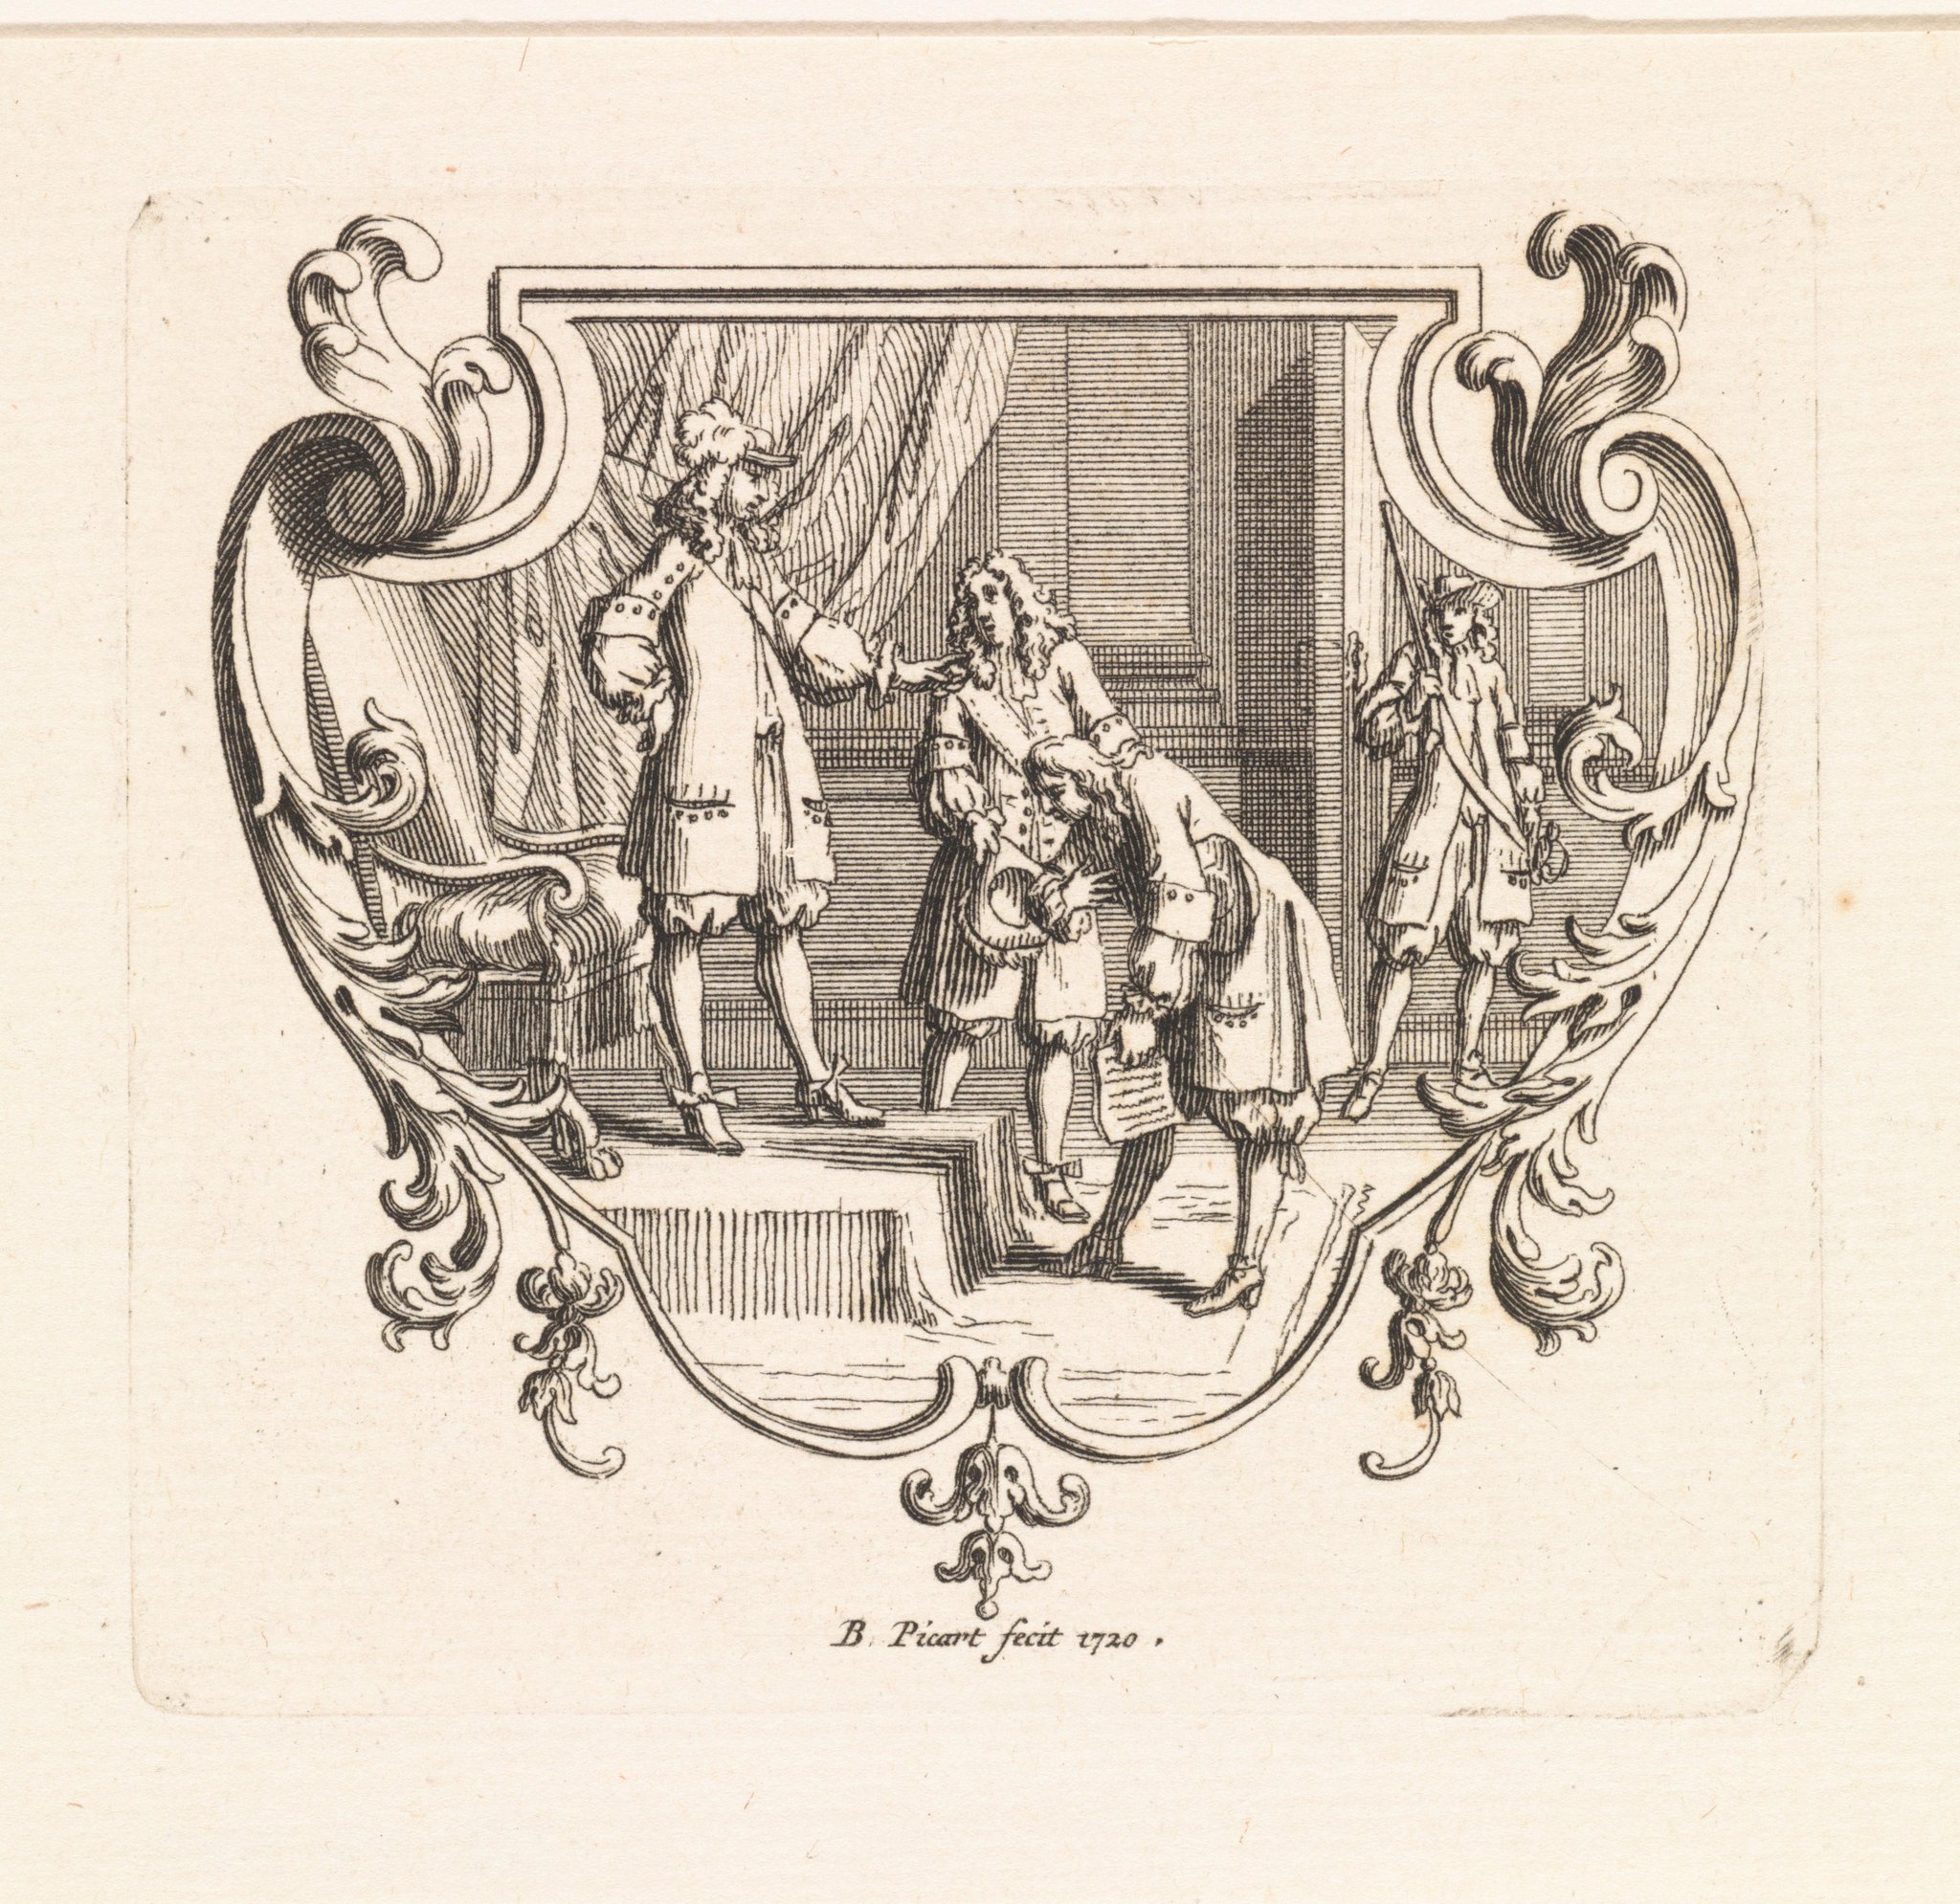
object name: print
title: Boodschapper bij een vorst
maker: bernard picart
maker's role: draughtsman, print maker, publisher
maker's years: 1673-1733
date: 1720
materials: paper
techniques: engraving, etching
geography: amsterdam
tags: messenger, ruler, sovereign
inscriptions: collector's mark: Lugt 2228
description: Een boodschapper met een brief buigt voor een vorst. De vorst is opgestaan van zijn troon. De voorstelling is gevat in een ornamenteel kader.